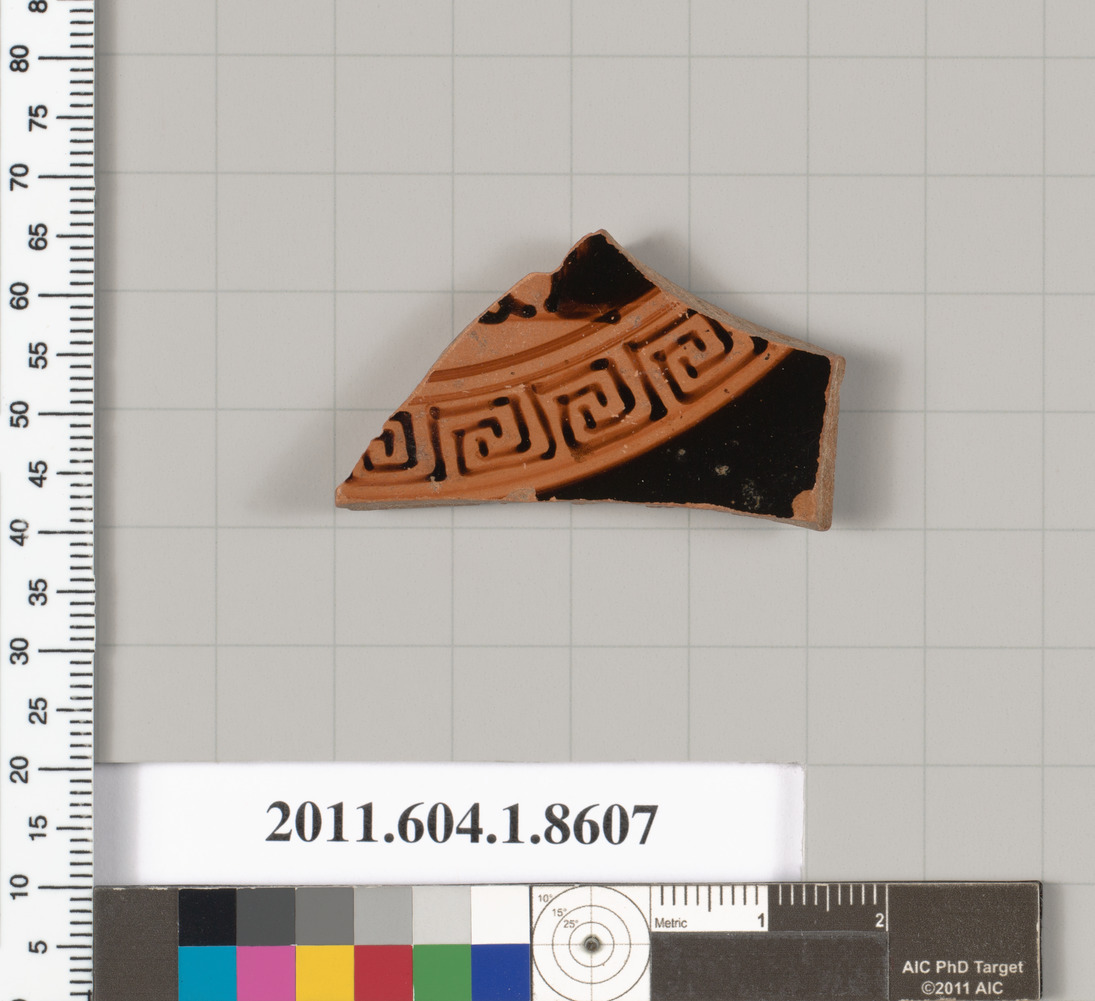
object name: kylix fragment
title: Terracotta fragment of a stemless kylix (drinking cup)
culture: greek, attic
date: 460-450 BCE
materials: terracotta